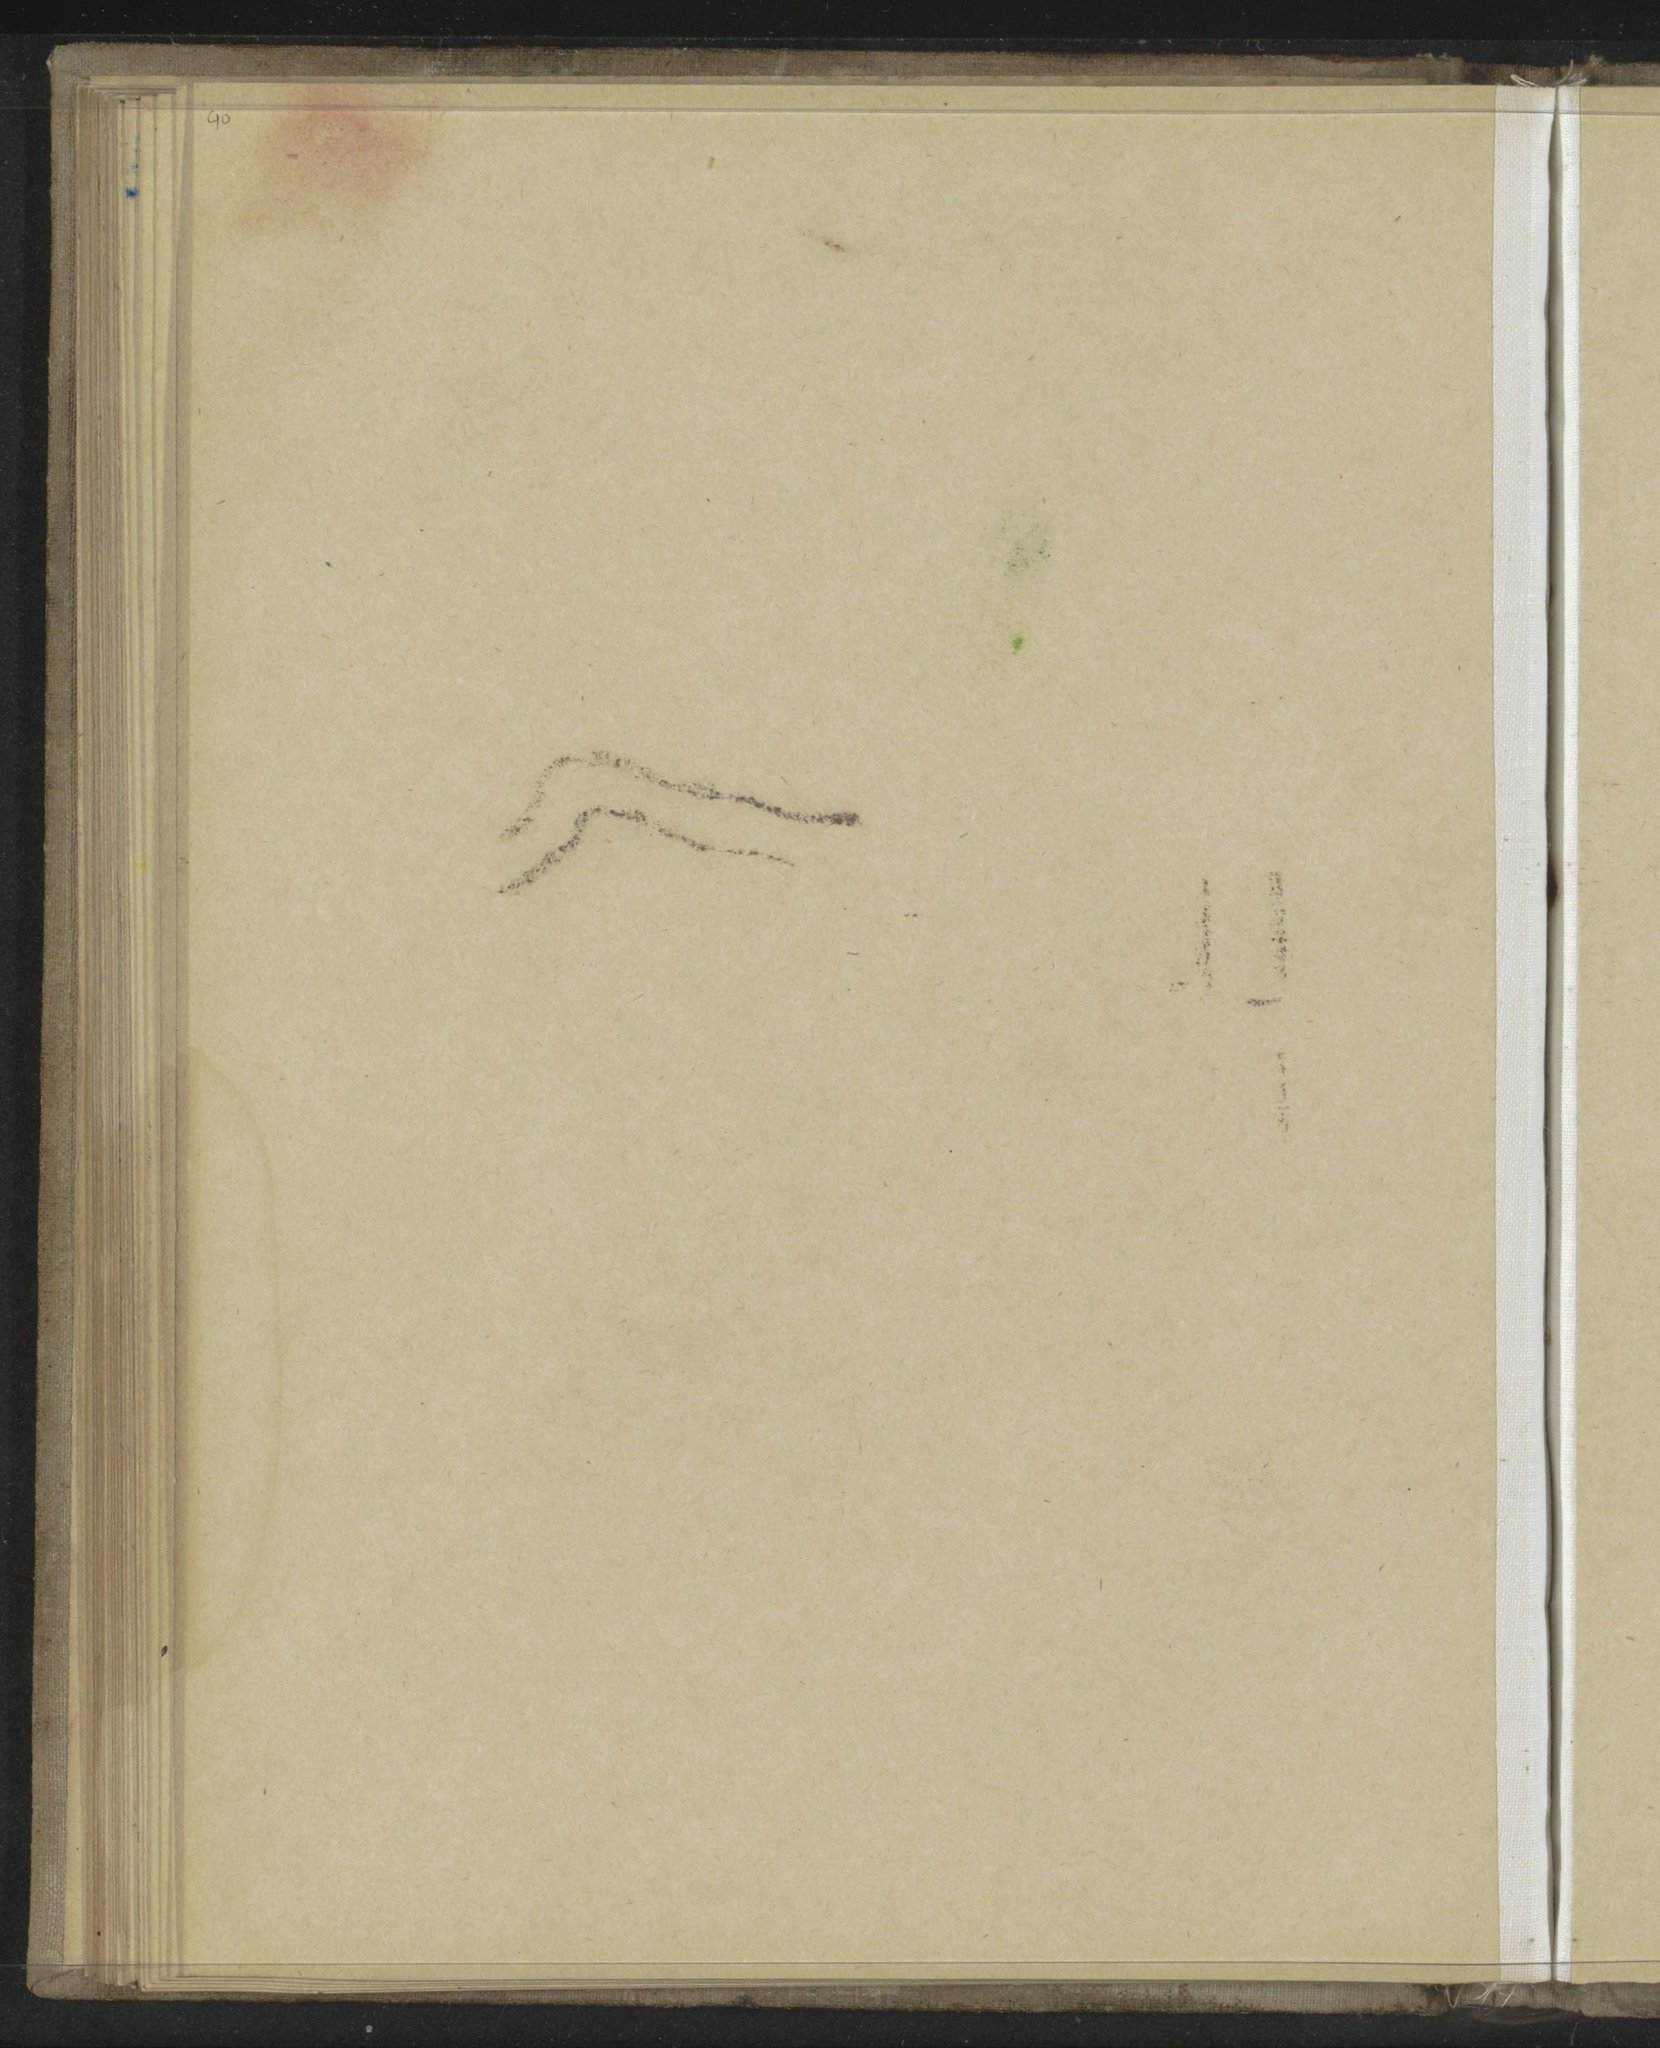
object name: sketchbook leaf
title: Studies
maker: willem witsen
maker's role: draughtsman, painter, print maker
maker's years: 1860-1923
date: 1892-1897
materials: chalk, paper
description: Pagina 40 uit een schetsboek met 24 bladen.